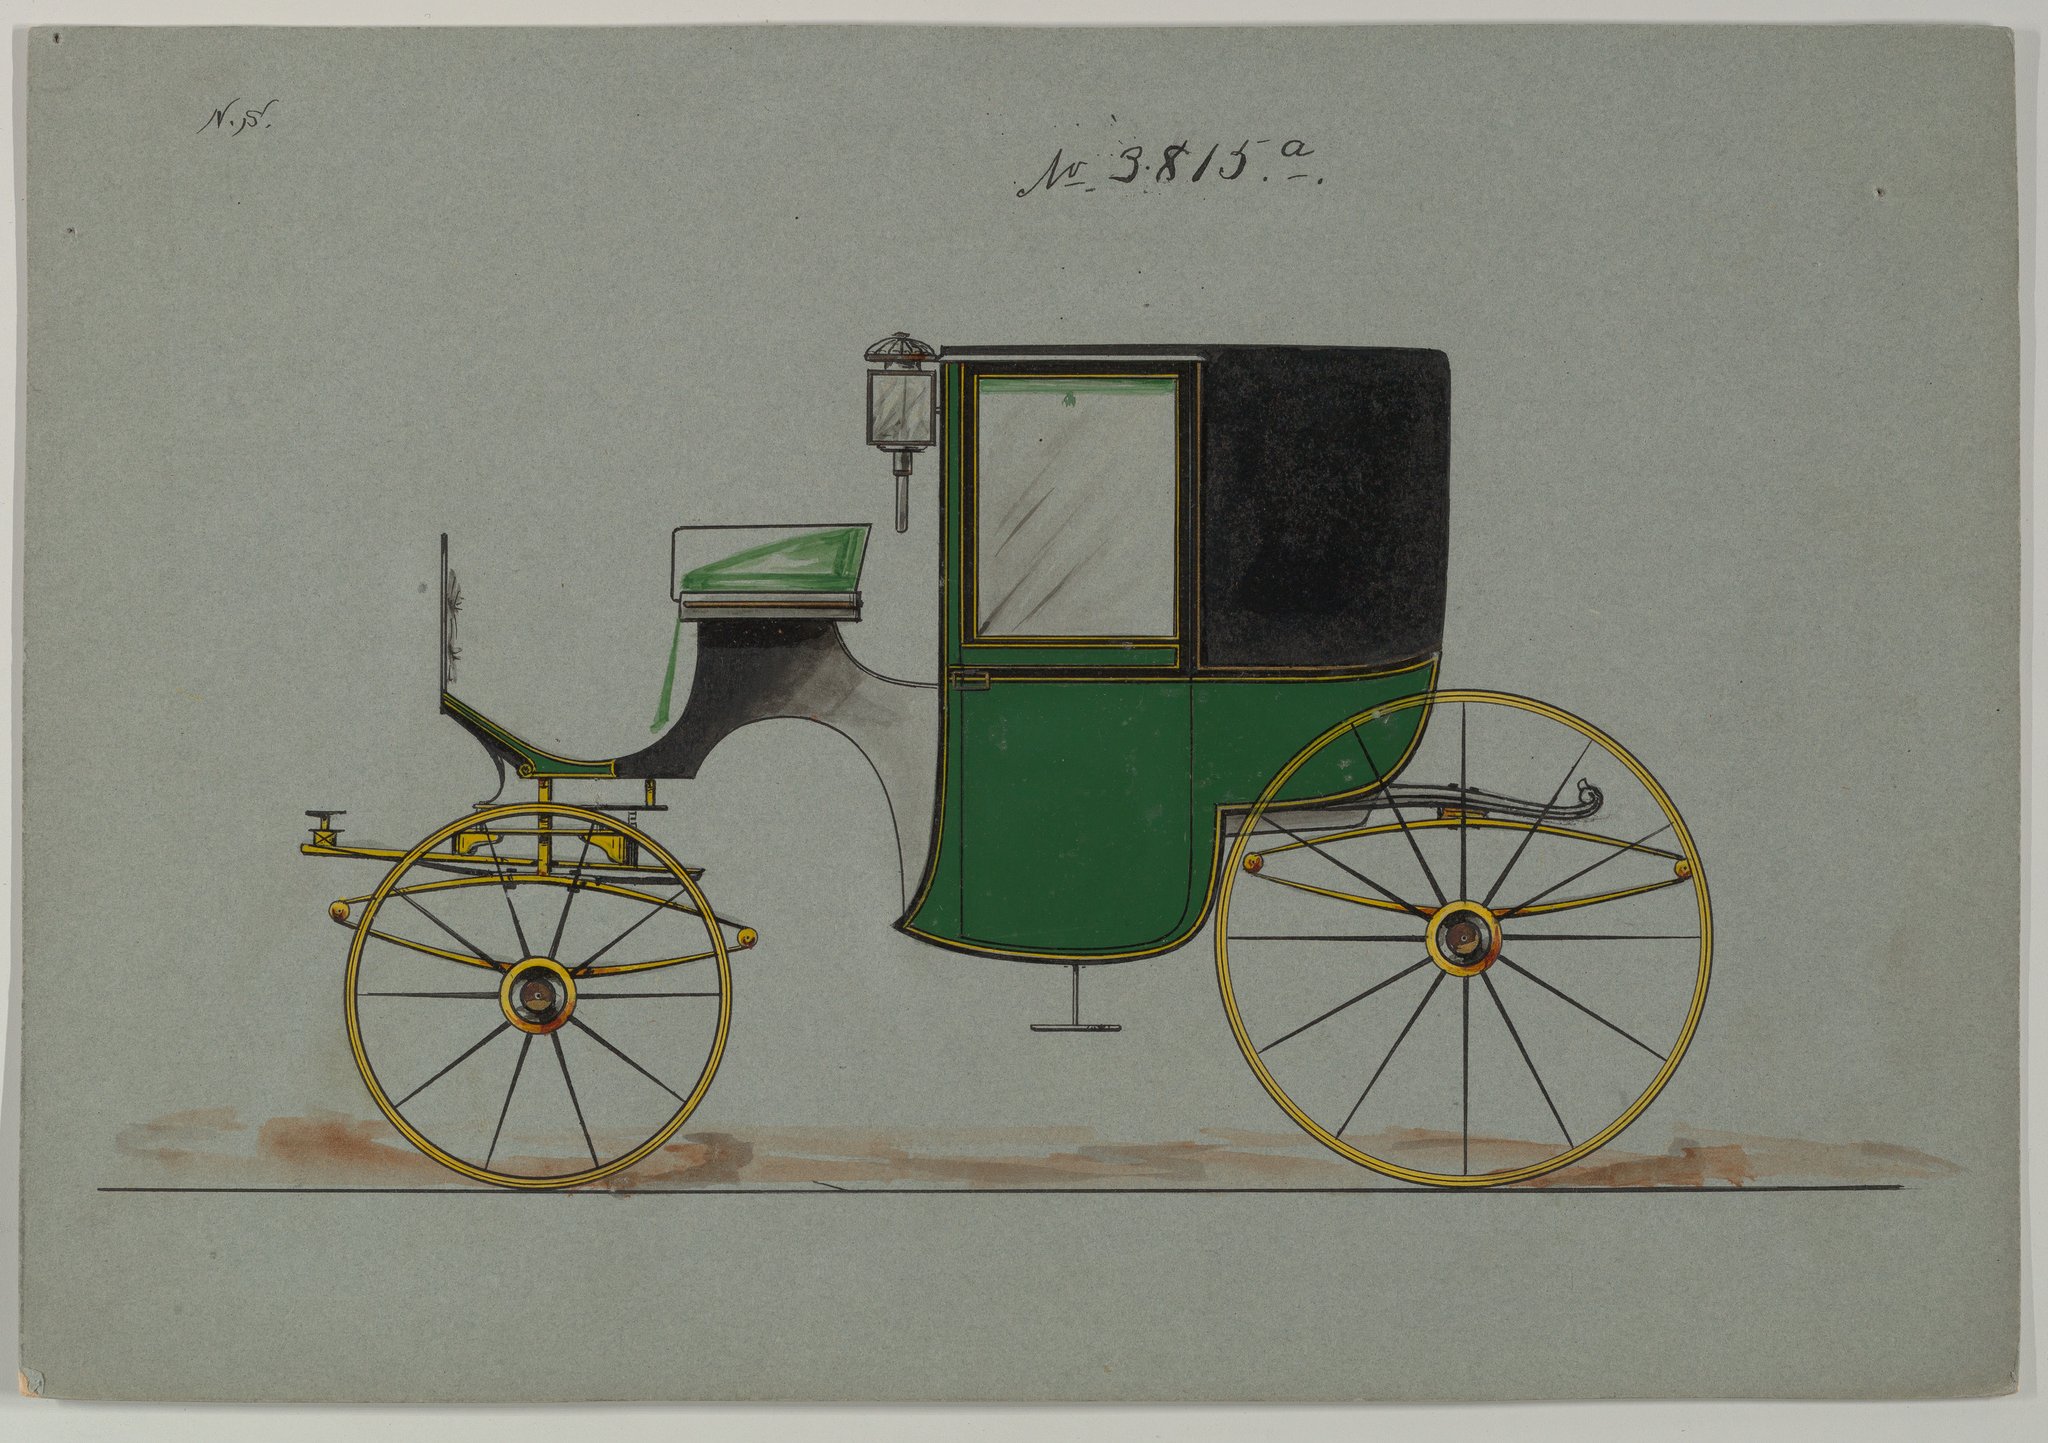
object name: drawing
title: Brougham #3815a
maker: brewster & co.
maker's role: manufacturer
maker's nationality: american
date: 1883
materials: gouache, gum arabic, ink, watercolor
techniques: pen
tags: carriages